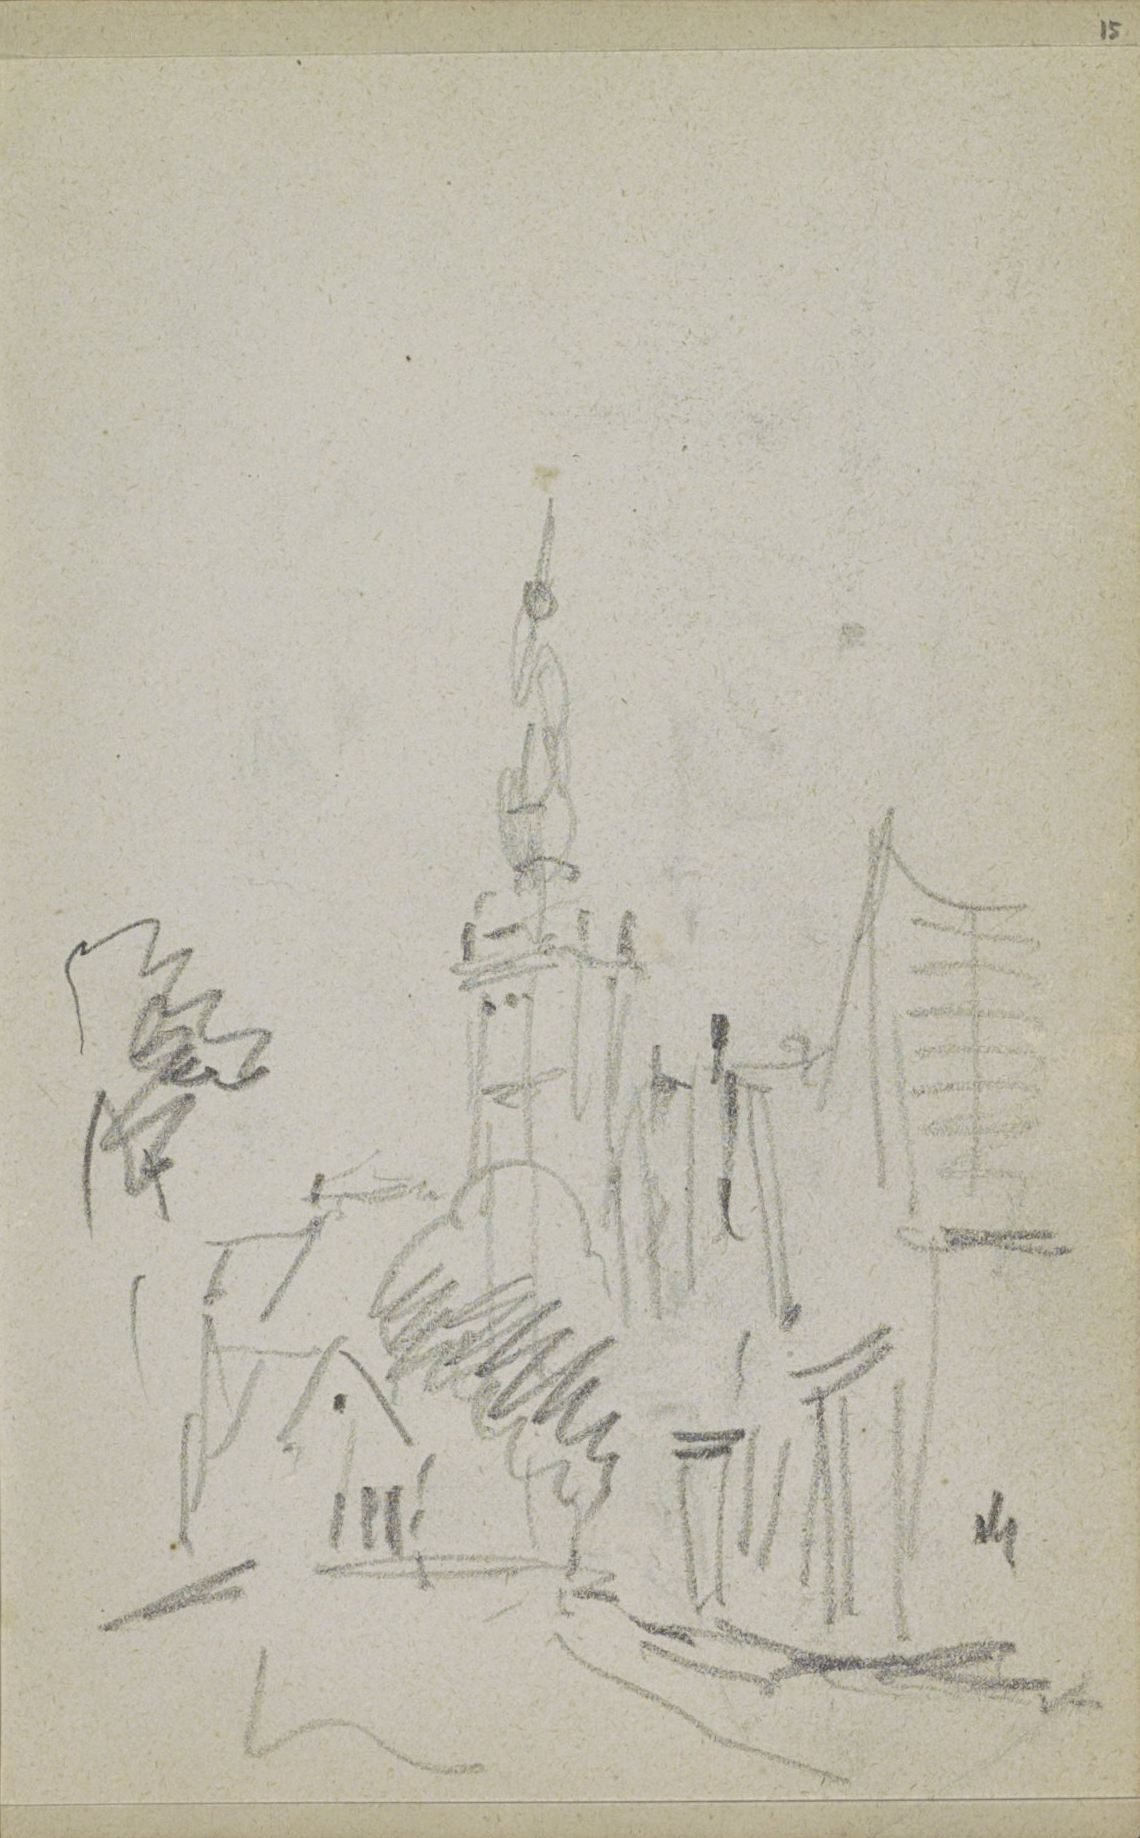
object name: sketchbook leaf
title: Gezicht op een straat met een toren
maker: adrianus eversen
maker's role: draughtsman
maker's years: 1818-1897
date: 1828-1897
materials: paper, pencil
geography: netherlands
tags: street, tower (of house or building)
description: Gezicht op een straat met een toren, mogelijk een kerktoren. Blad 15 recto uit een schetsboek met 58 bladen.